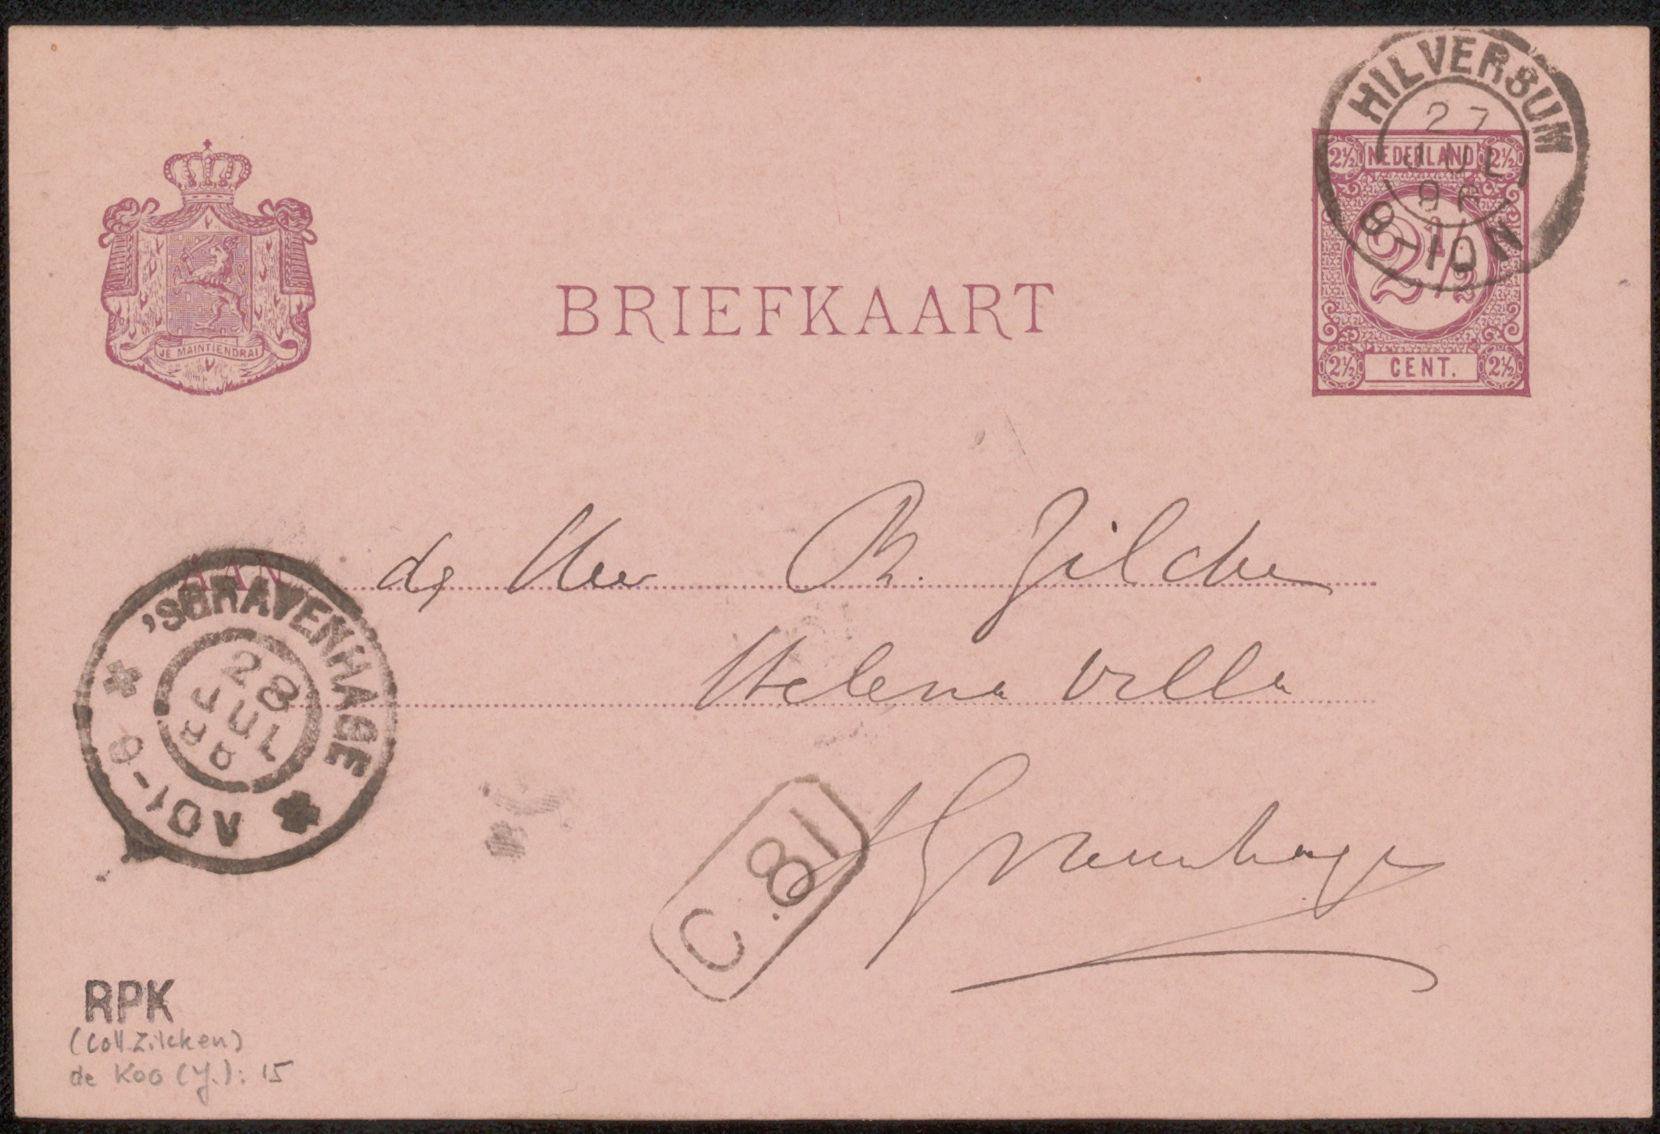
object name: postcard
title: Briefkaart aan Philip Zilcken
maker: johannes de koo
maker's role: auteur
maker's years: 1841-1909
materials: cardboard, ink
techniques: pen, writing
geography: hilversum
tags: the hague, painter, draughtsman, philip zilcken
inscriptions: collector's mark: ‘RPK’